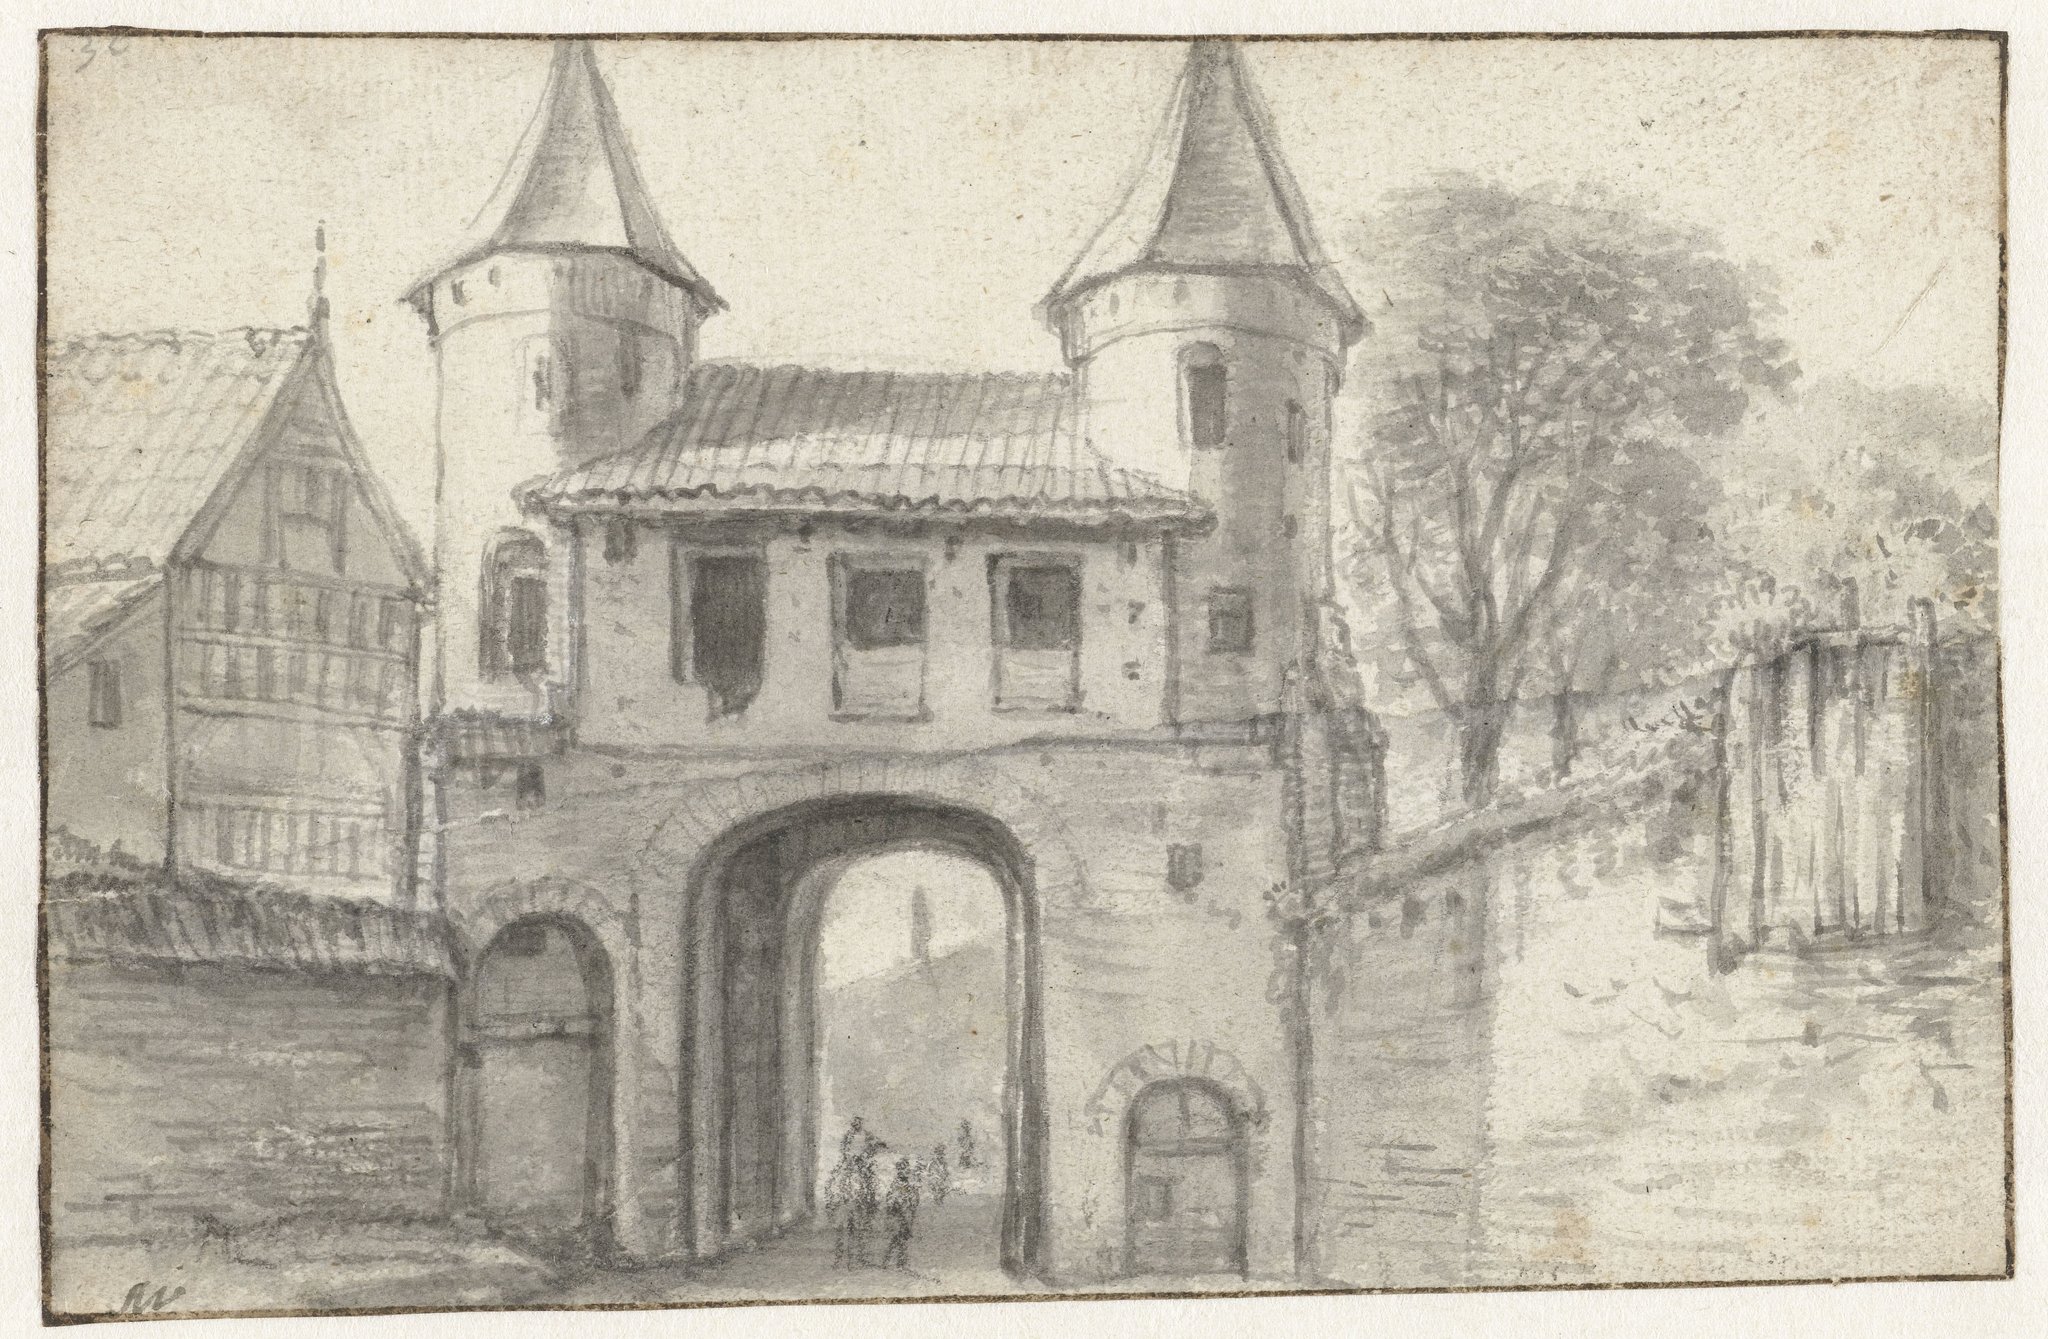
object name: drawing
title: Stadspoort te Hamburg (?), vanuit de binnenzijde gezien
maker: anthonie waterloo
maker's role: draughtsman, painter, print maker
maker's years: 1609-1690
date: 1619-1690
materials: chalk, paper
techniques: brush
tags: city-gate